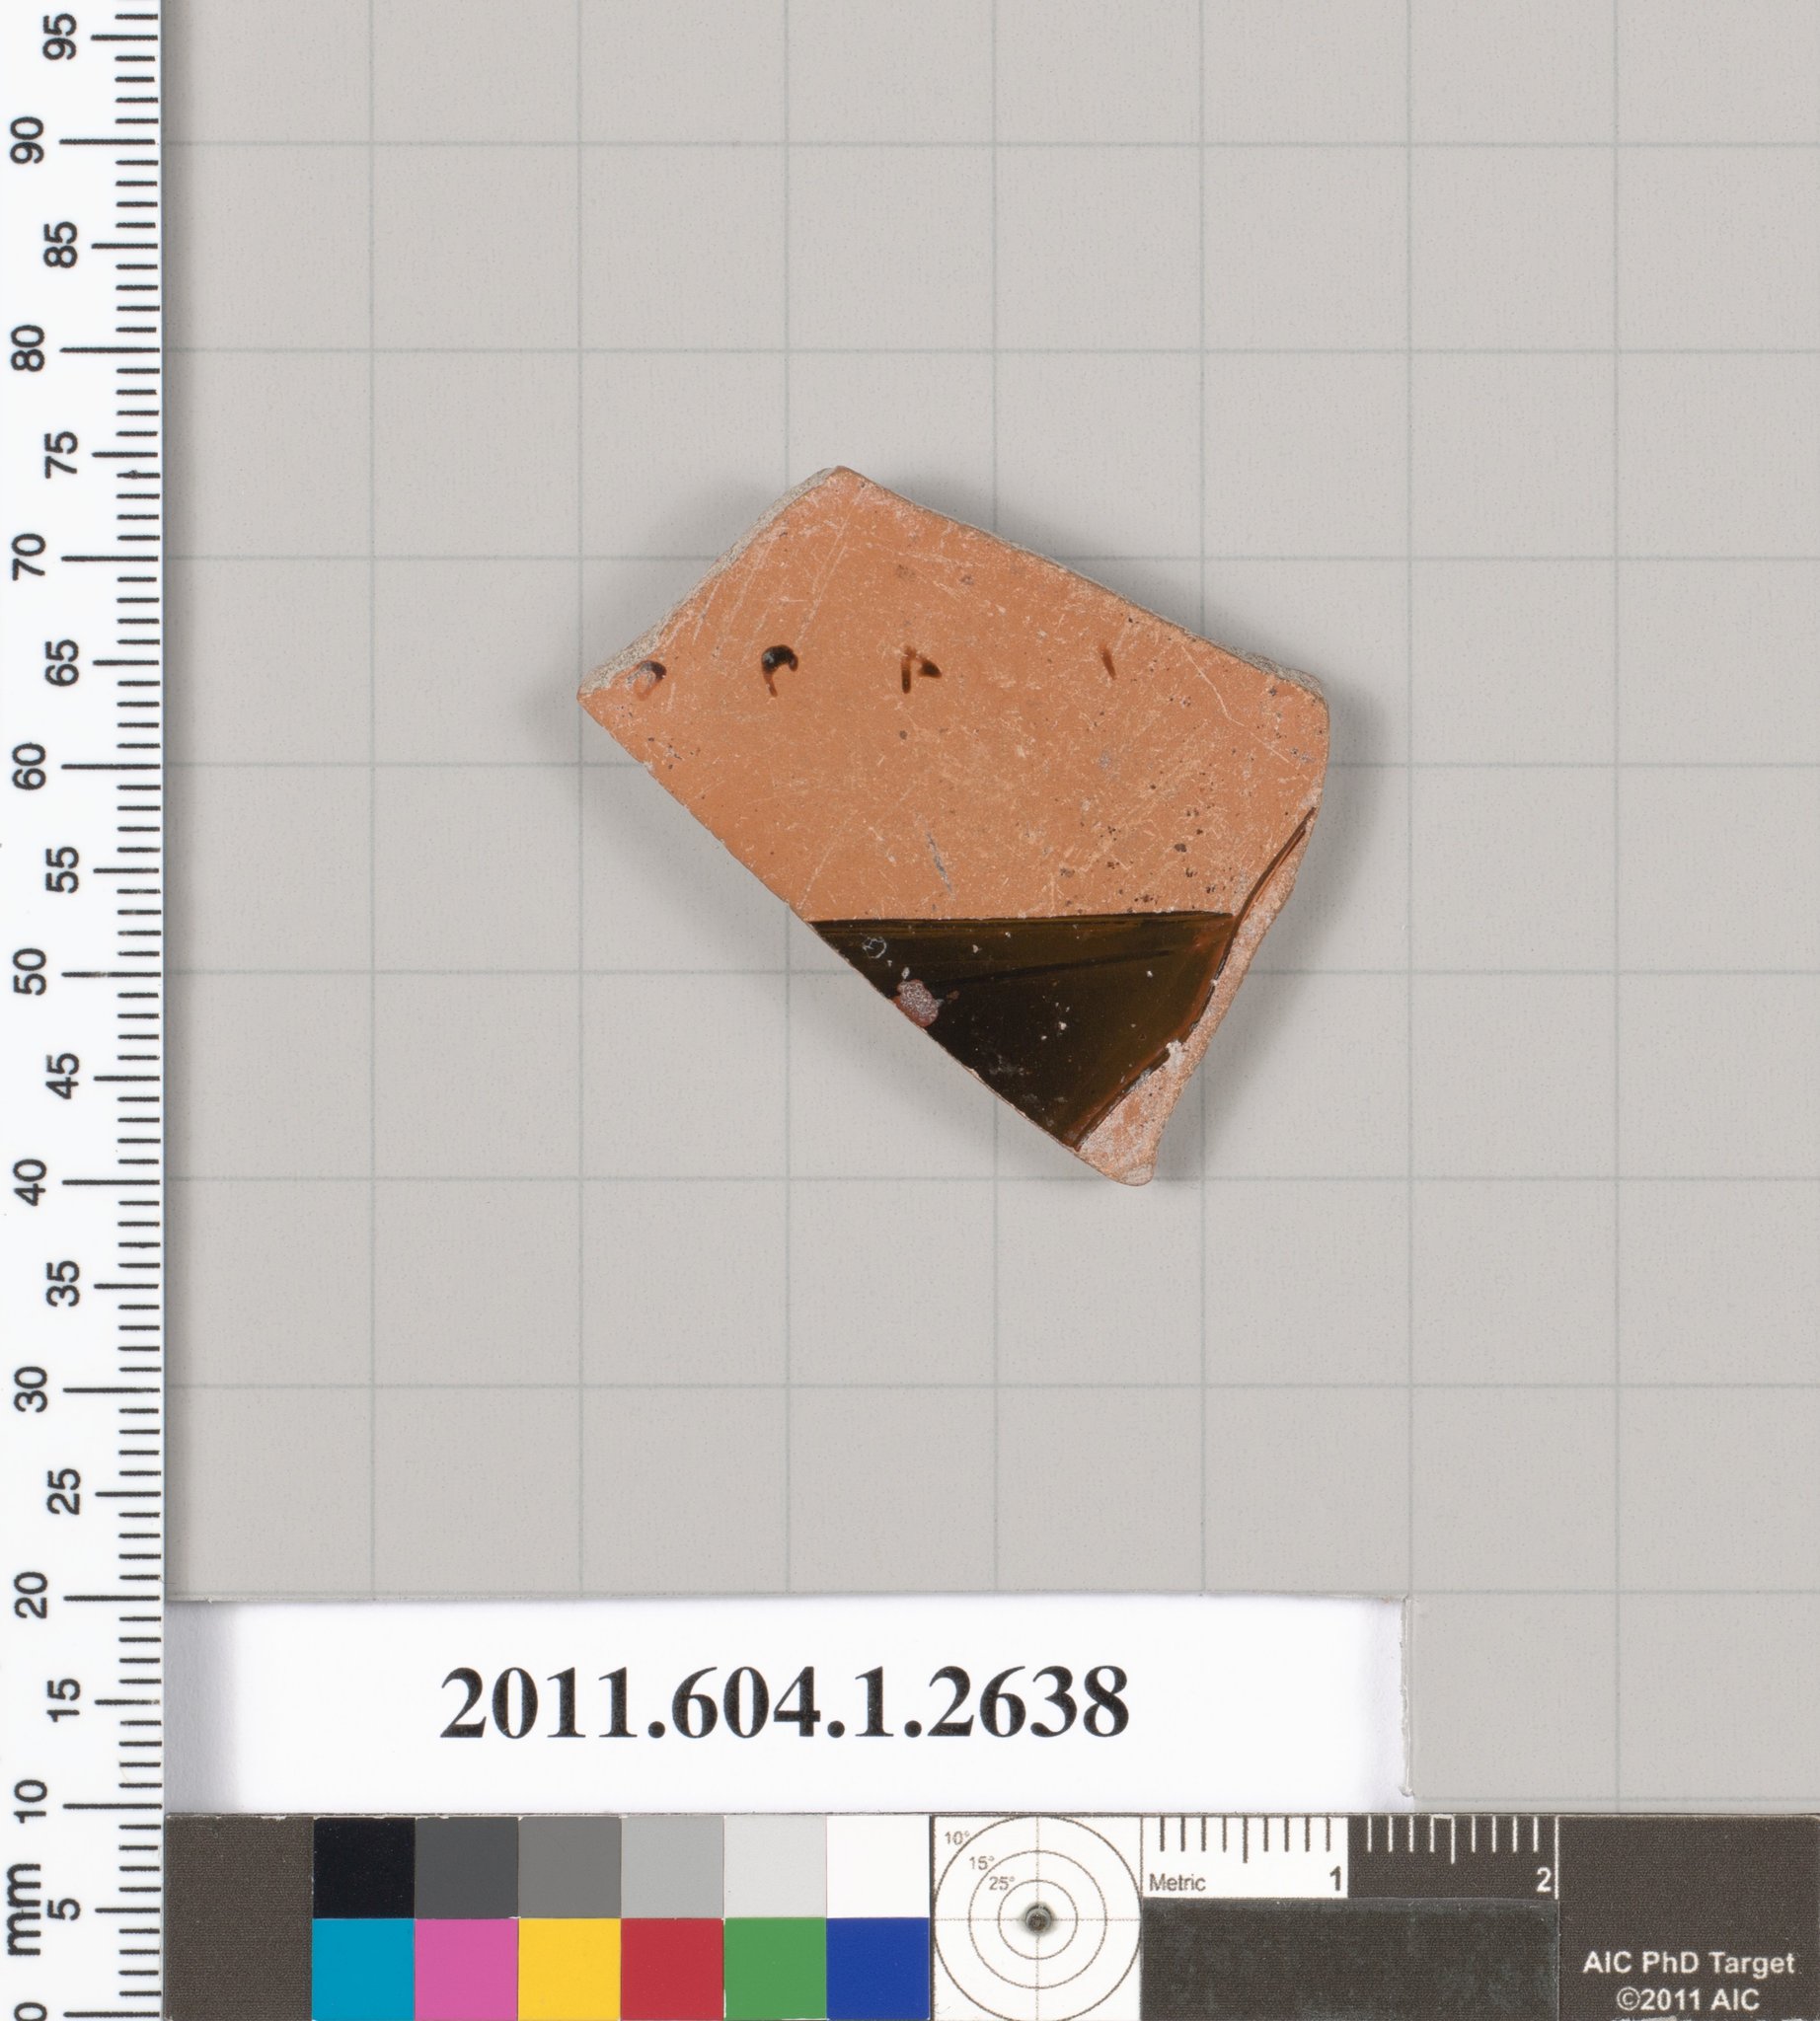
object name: kylix fragment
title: Terracotta fragment of a kylix (drinking cup)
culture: greek, attic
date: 520-500 BCE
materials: terracotta